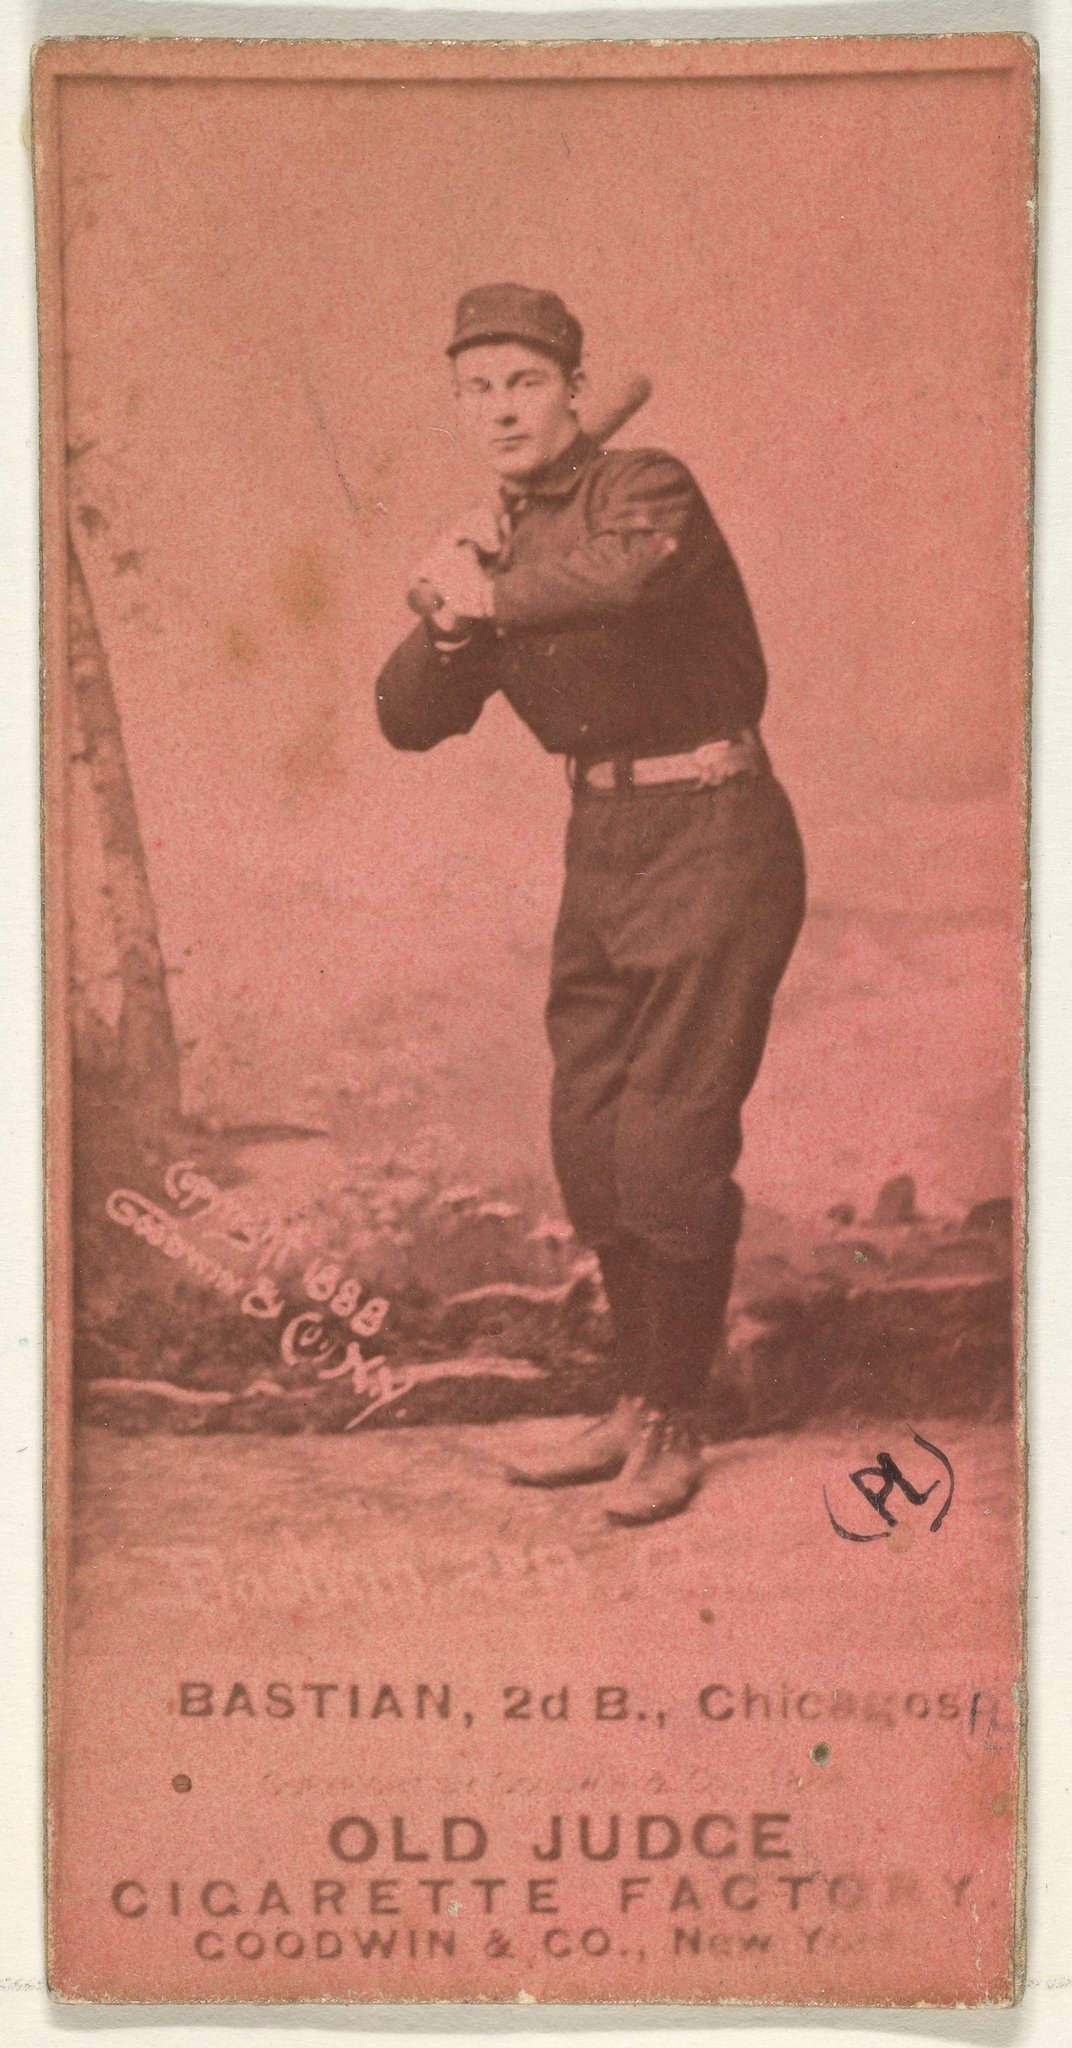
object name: baseball card, photograph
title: Bastian, 2nd Base, Chicago, from the Old Judge series (N172) for Old Judge Cigarettes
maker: goodwin & company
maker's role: publisher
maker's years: 1850-1950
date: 1888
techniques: albumen silver print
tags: men,portraits,baseball,athletes